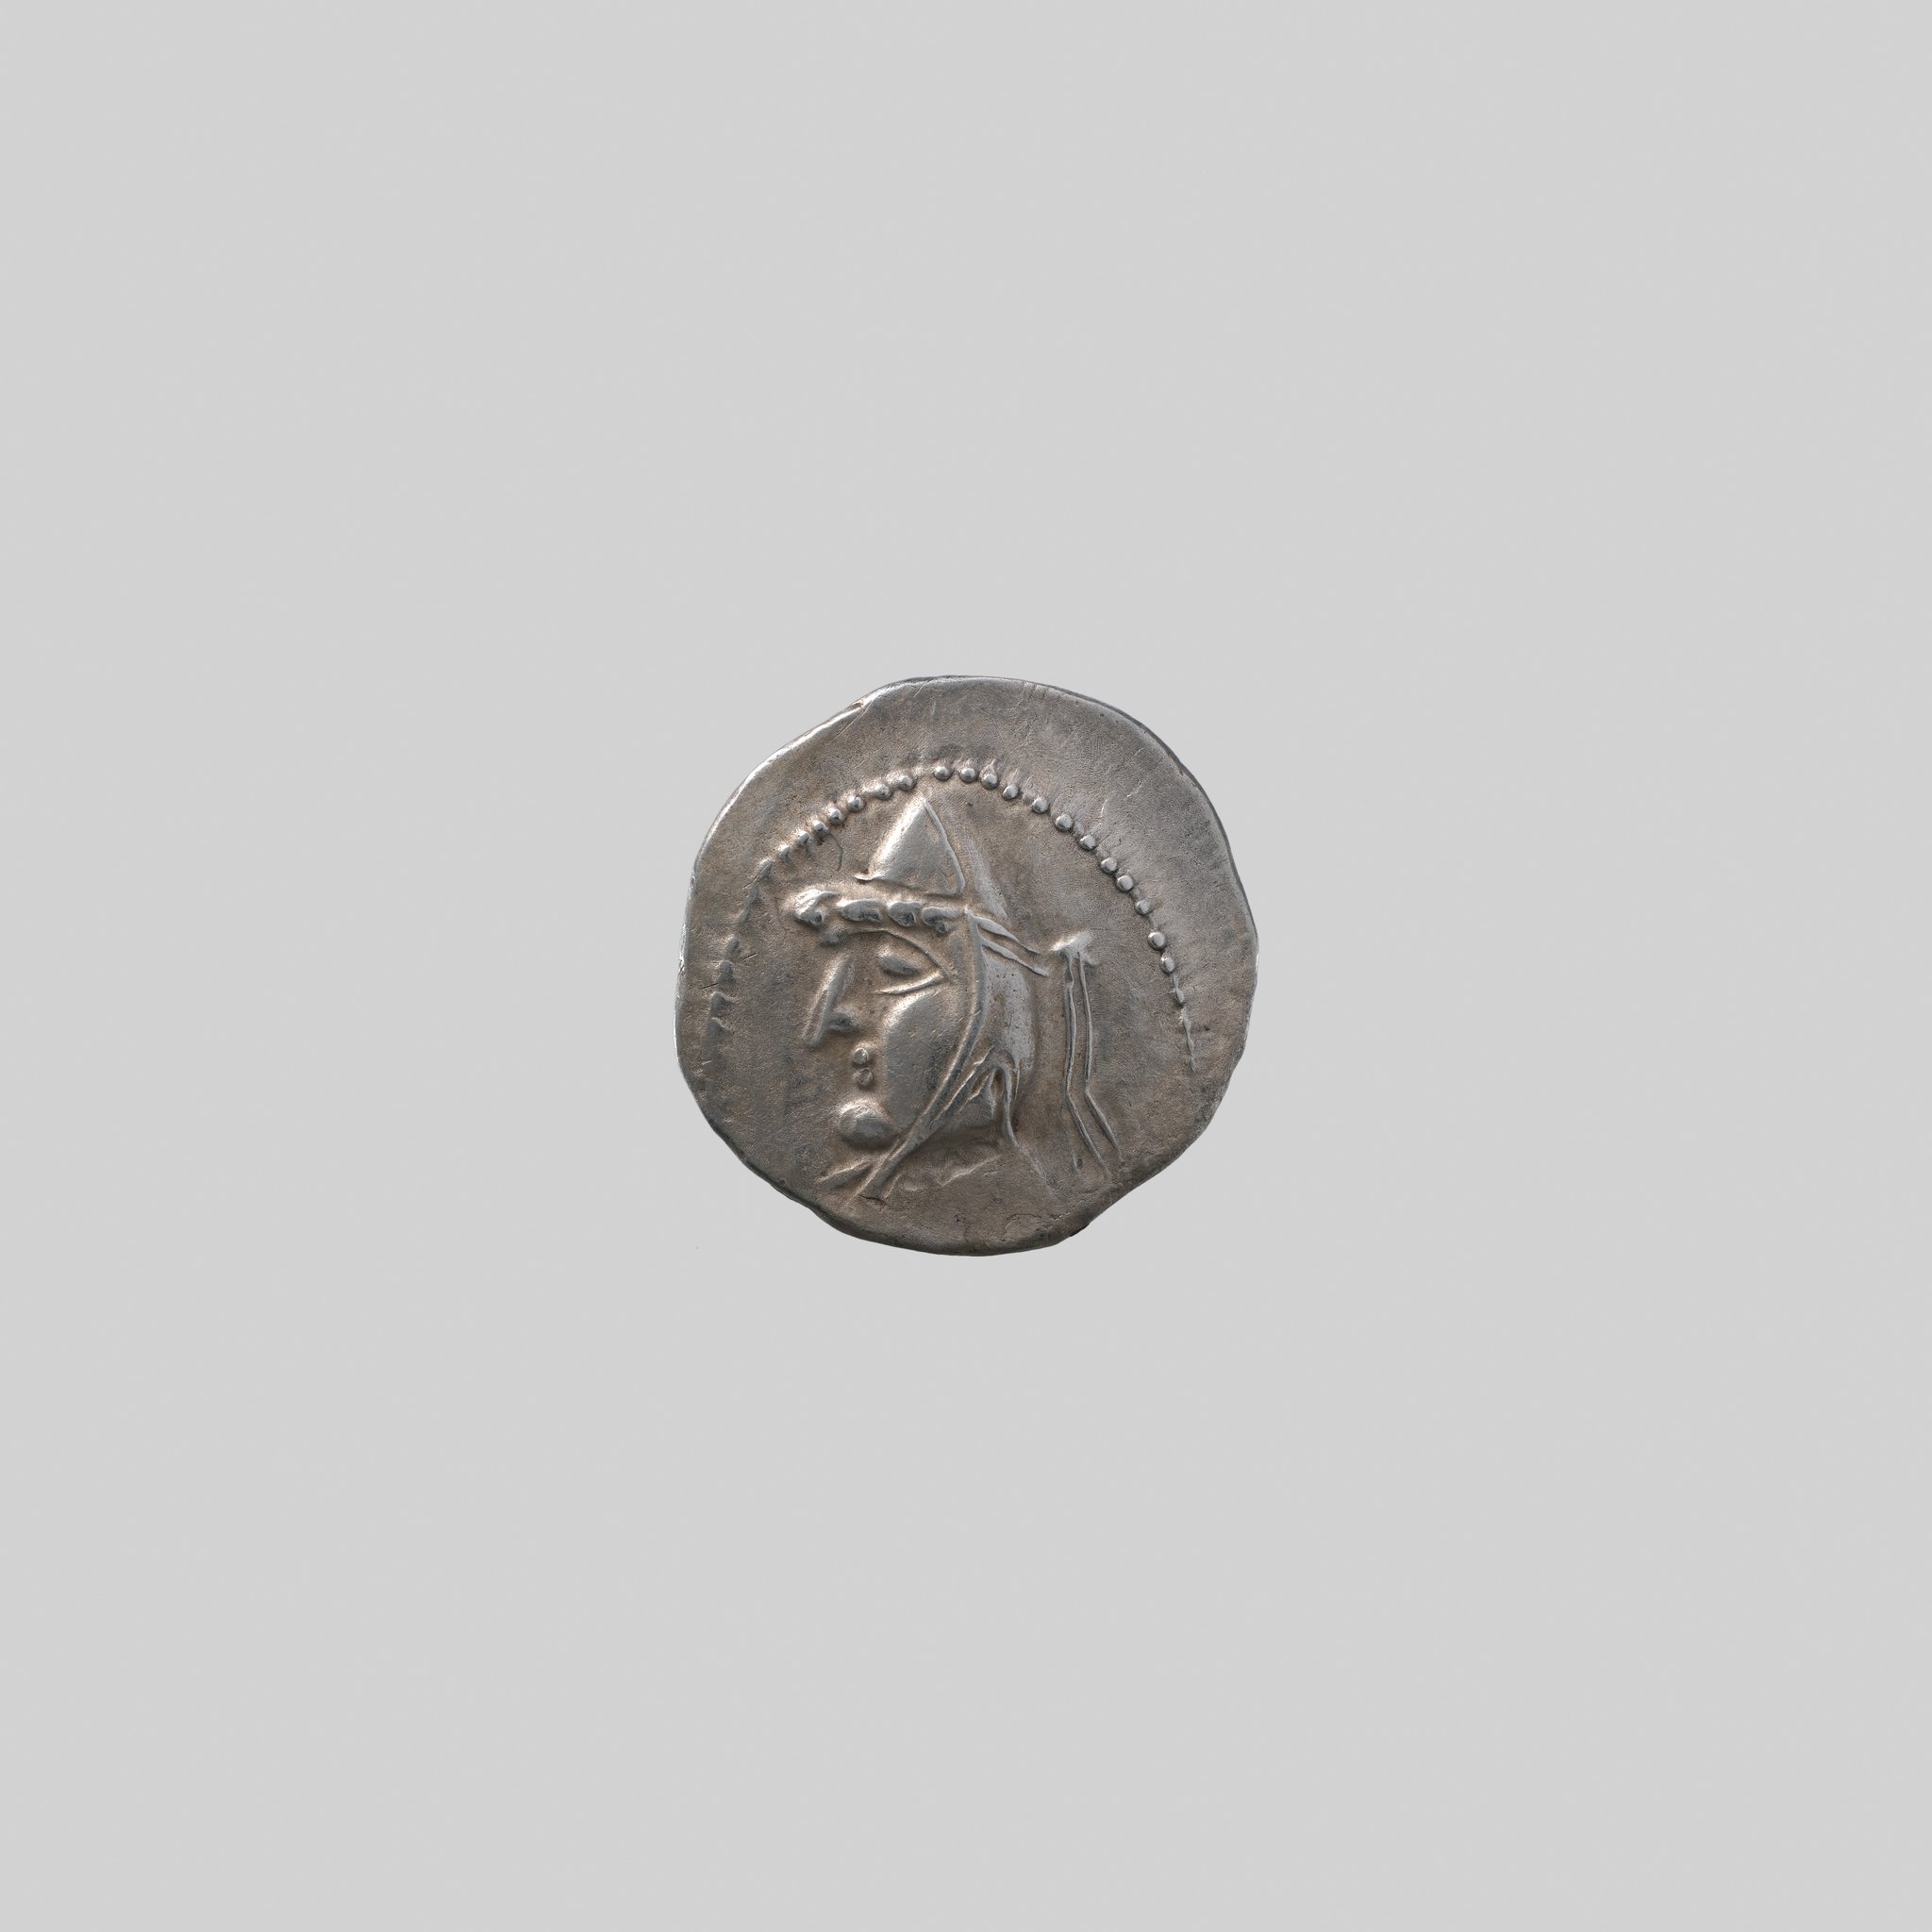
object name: coin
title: Drachm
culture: parthian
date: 171-138 BCE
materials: silver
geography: iran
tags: profiles